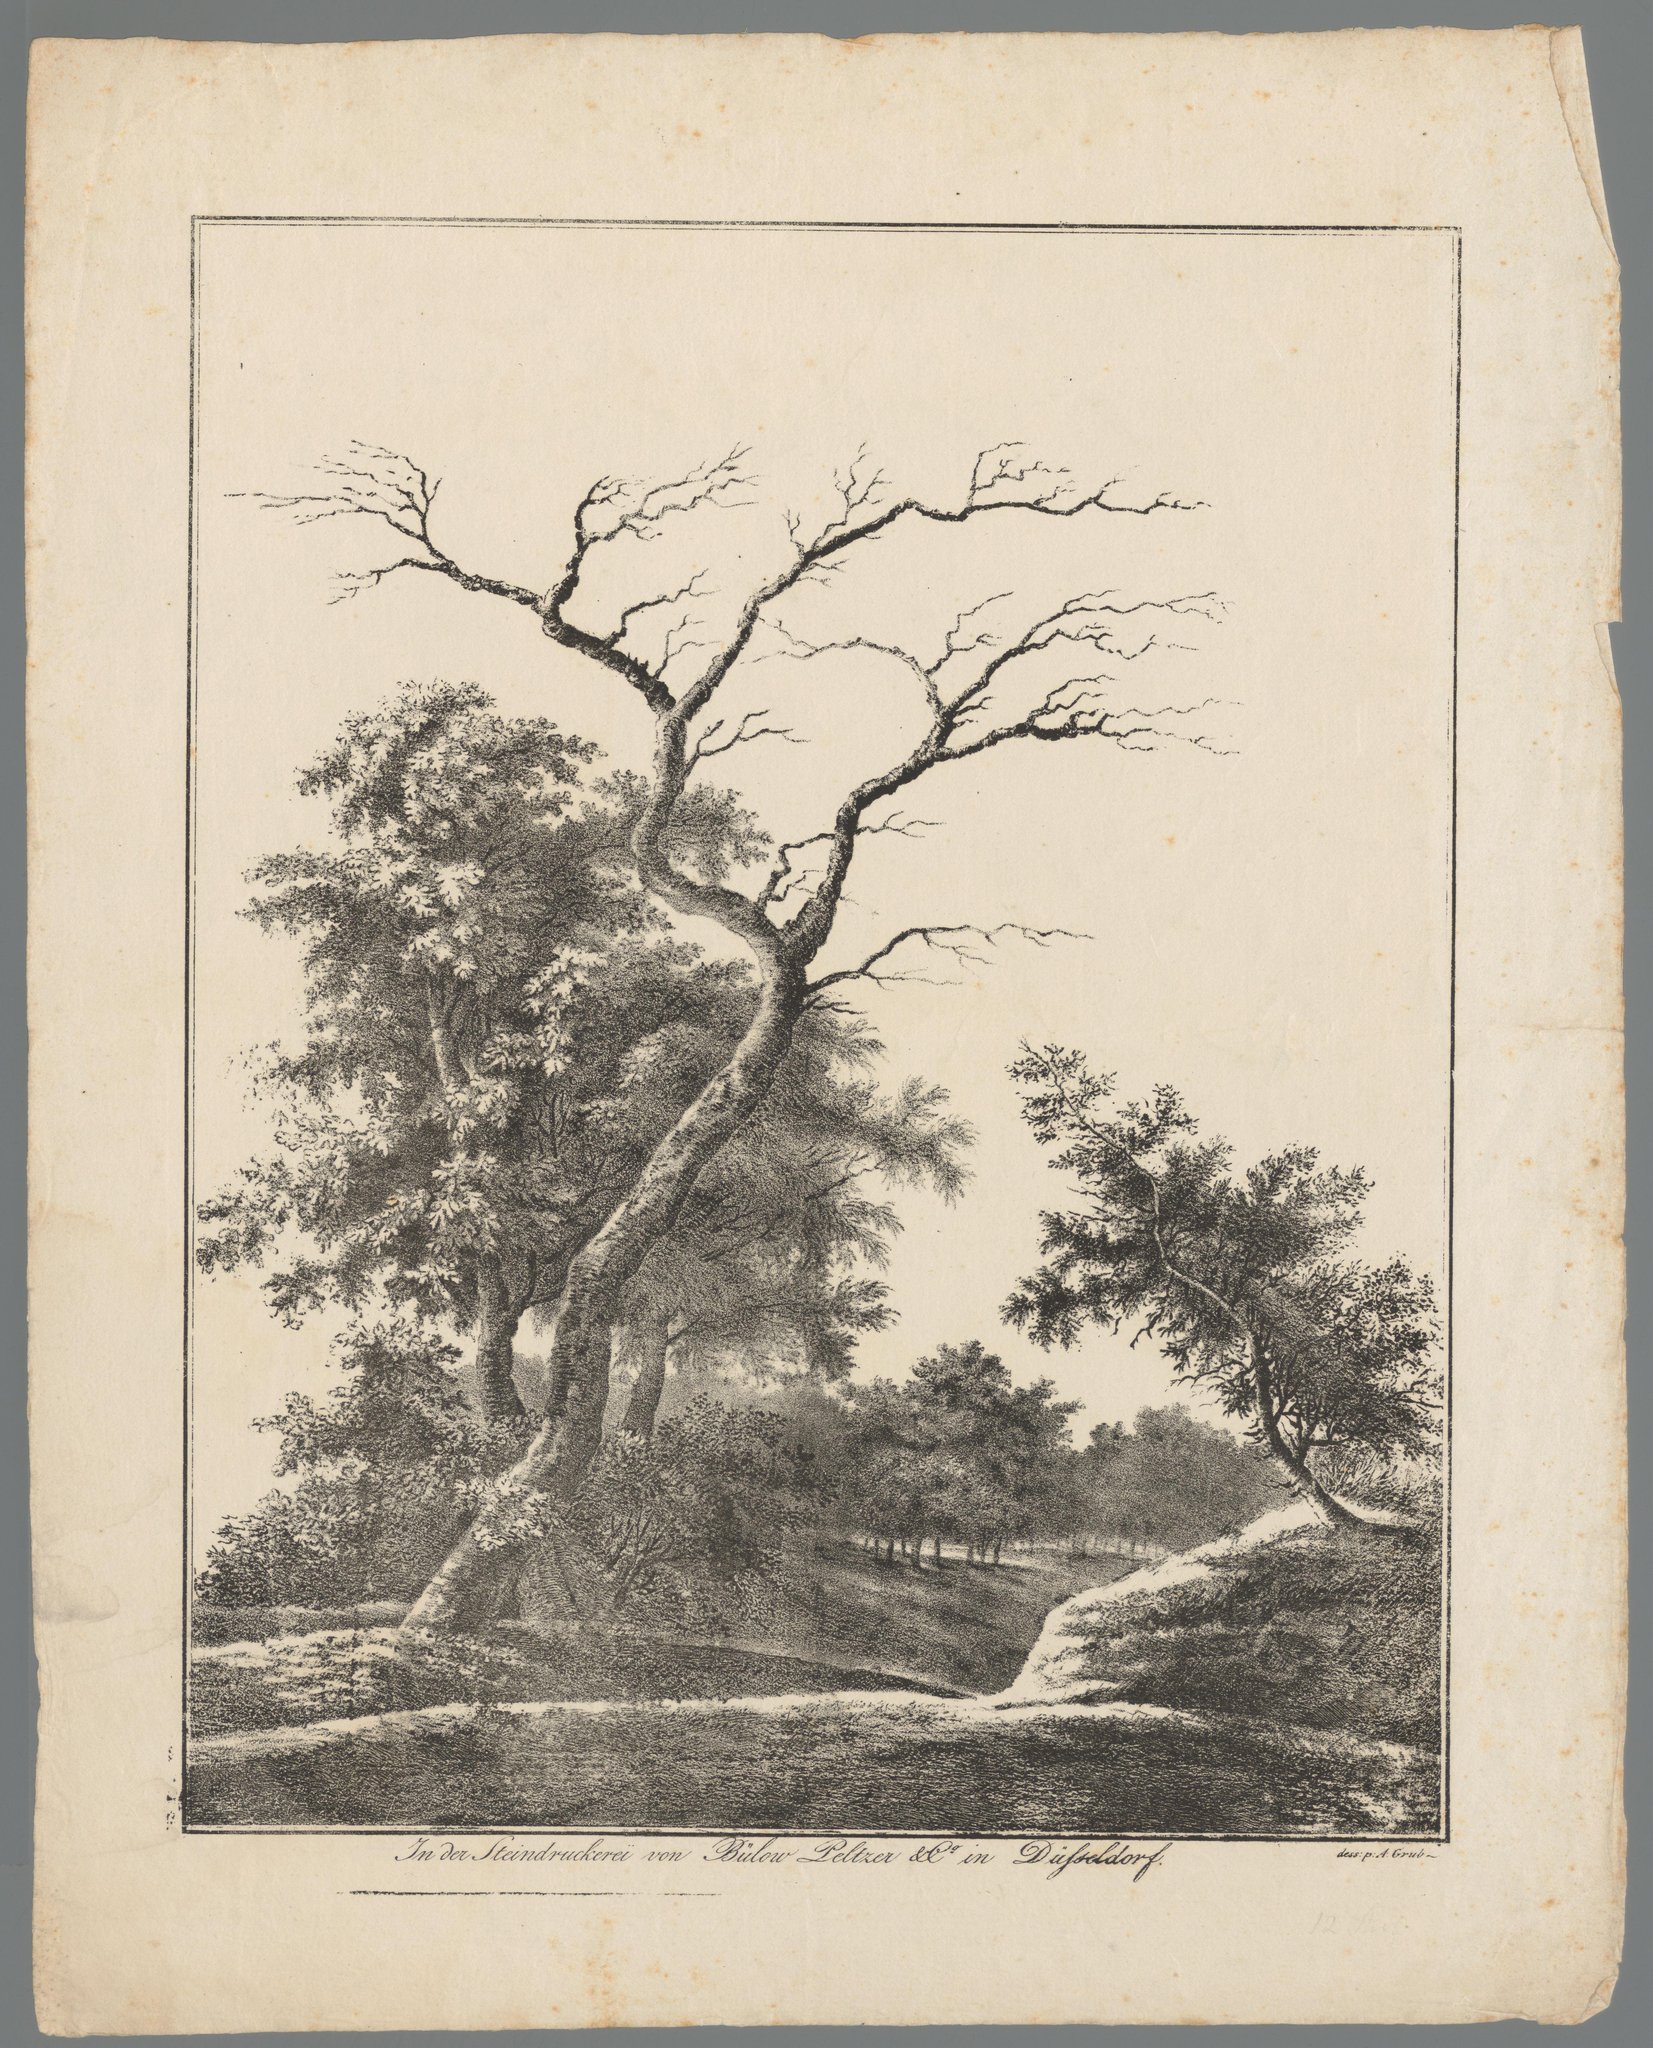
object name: print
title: Boomrijk landschap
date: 1800-1850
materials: paper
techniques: lithograph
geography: dusseldorf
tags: trees, landscapes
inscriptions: collector's mark: Lugt 2228